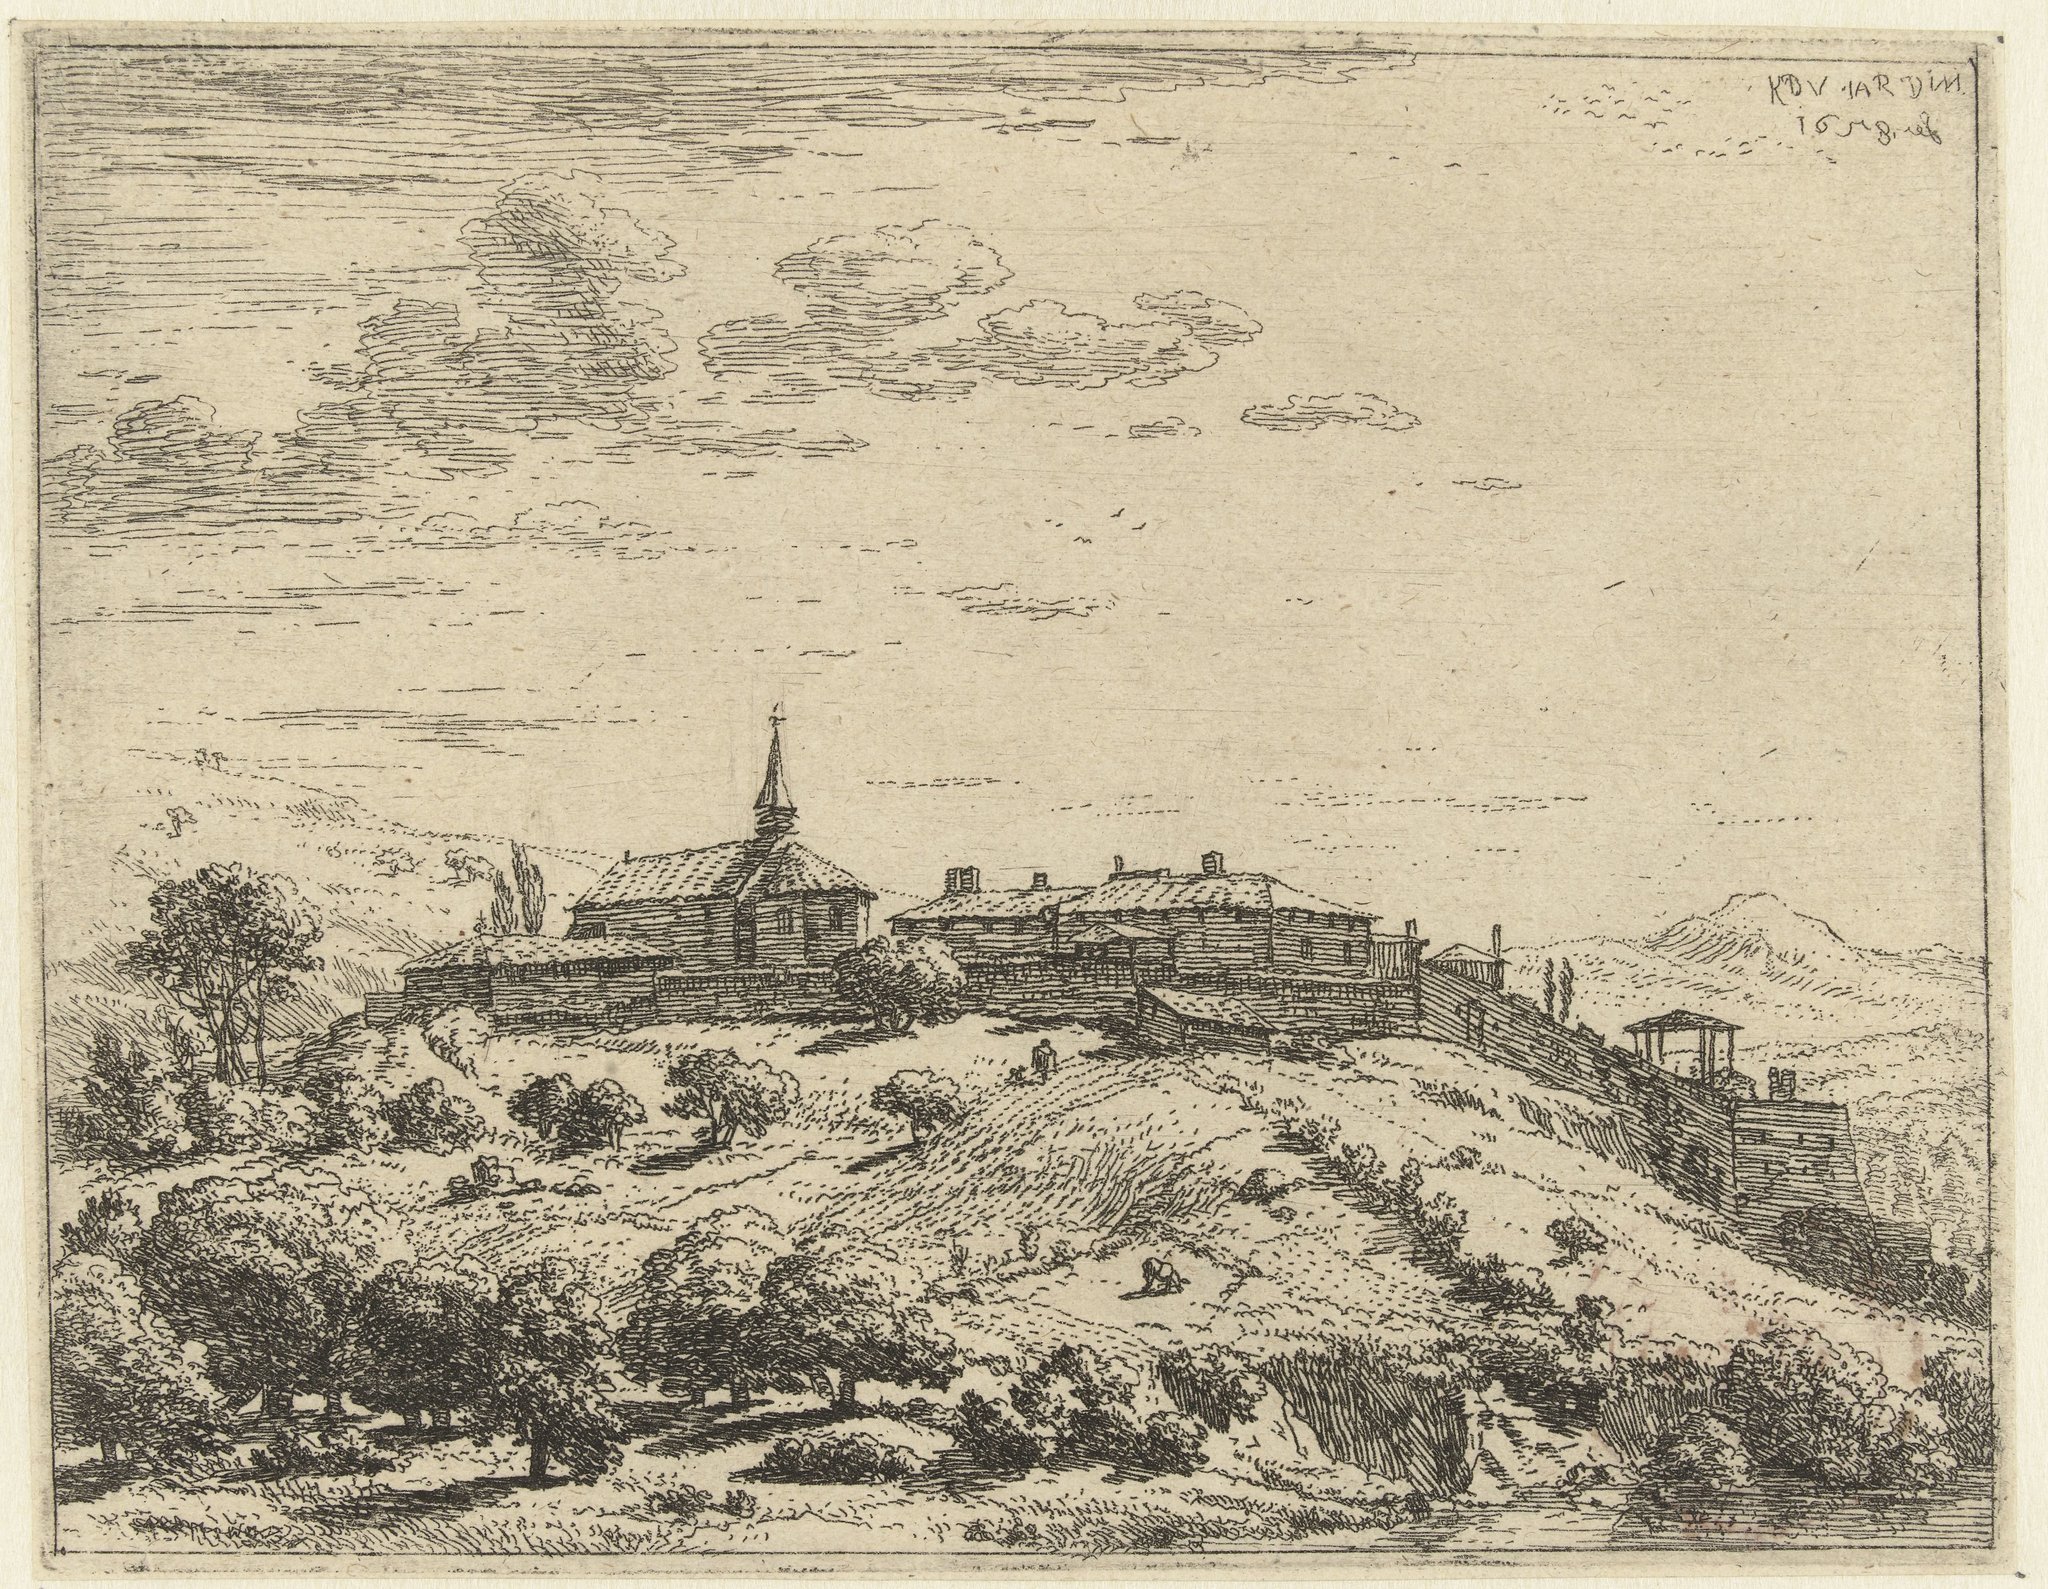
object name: print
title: Dorp op een heuvel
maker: karel du jardin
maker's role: draughtsman, painter, print maker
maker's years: 1626-1678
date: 1658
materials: paper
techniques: etching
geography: the hague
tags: prospect of village, silhouette of village, low hill country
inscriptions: collector's mark: Lugt 240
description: Hollstein nrs. 9-12 lijken deel uit te maken van een serie.